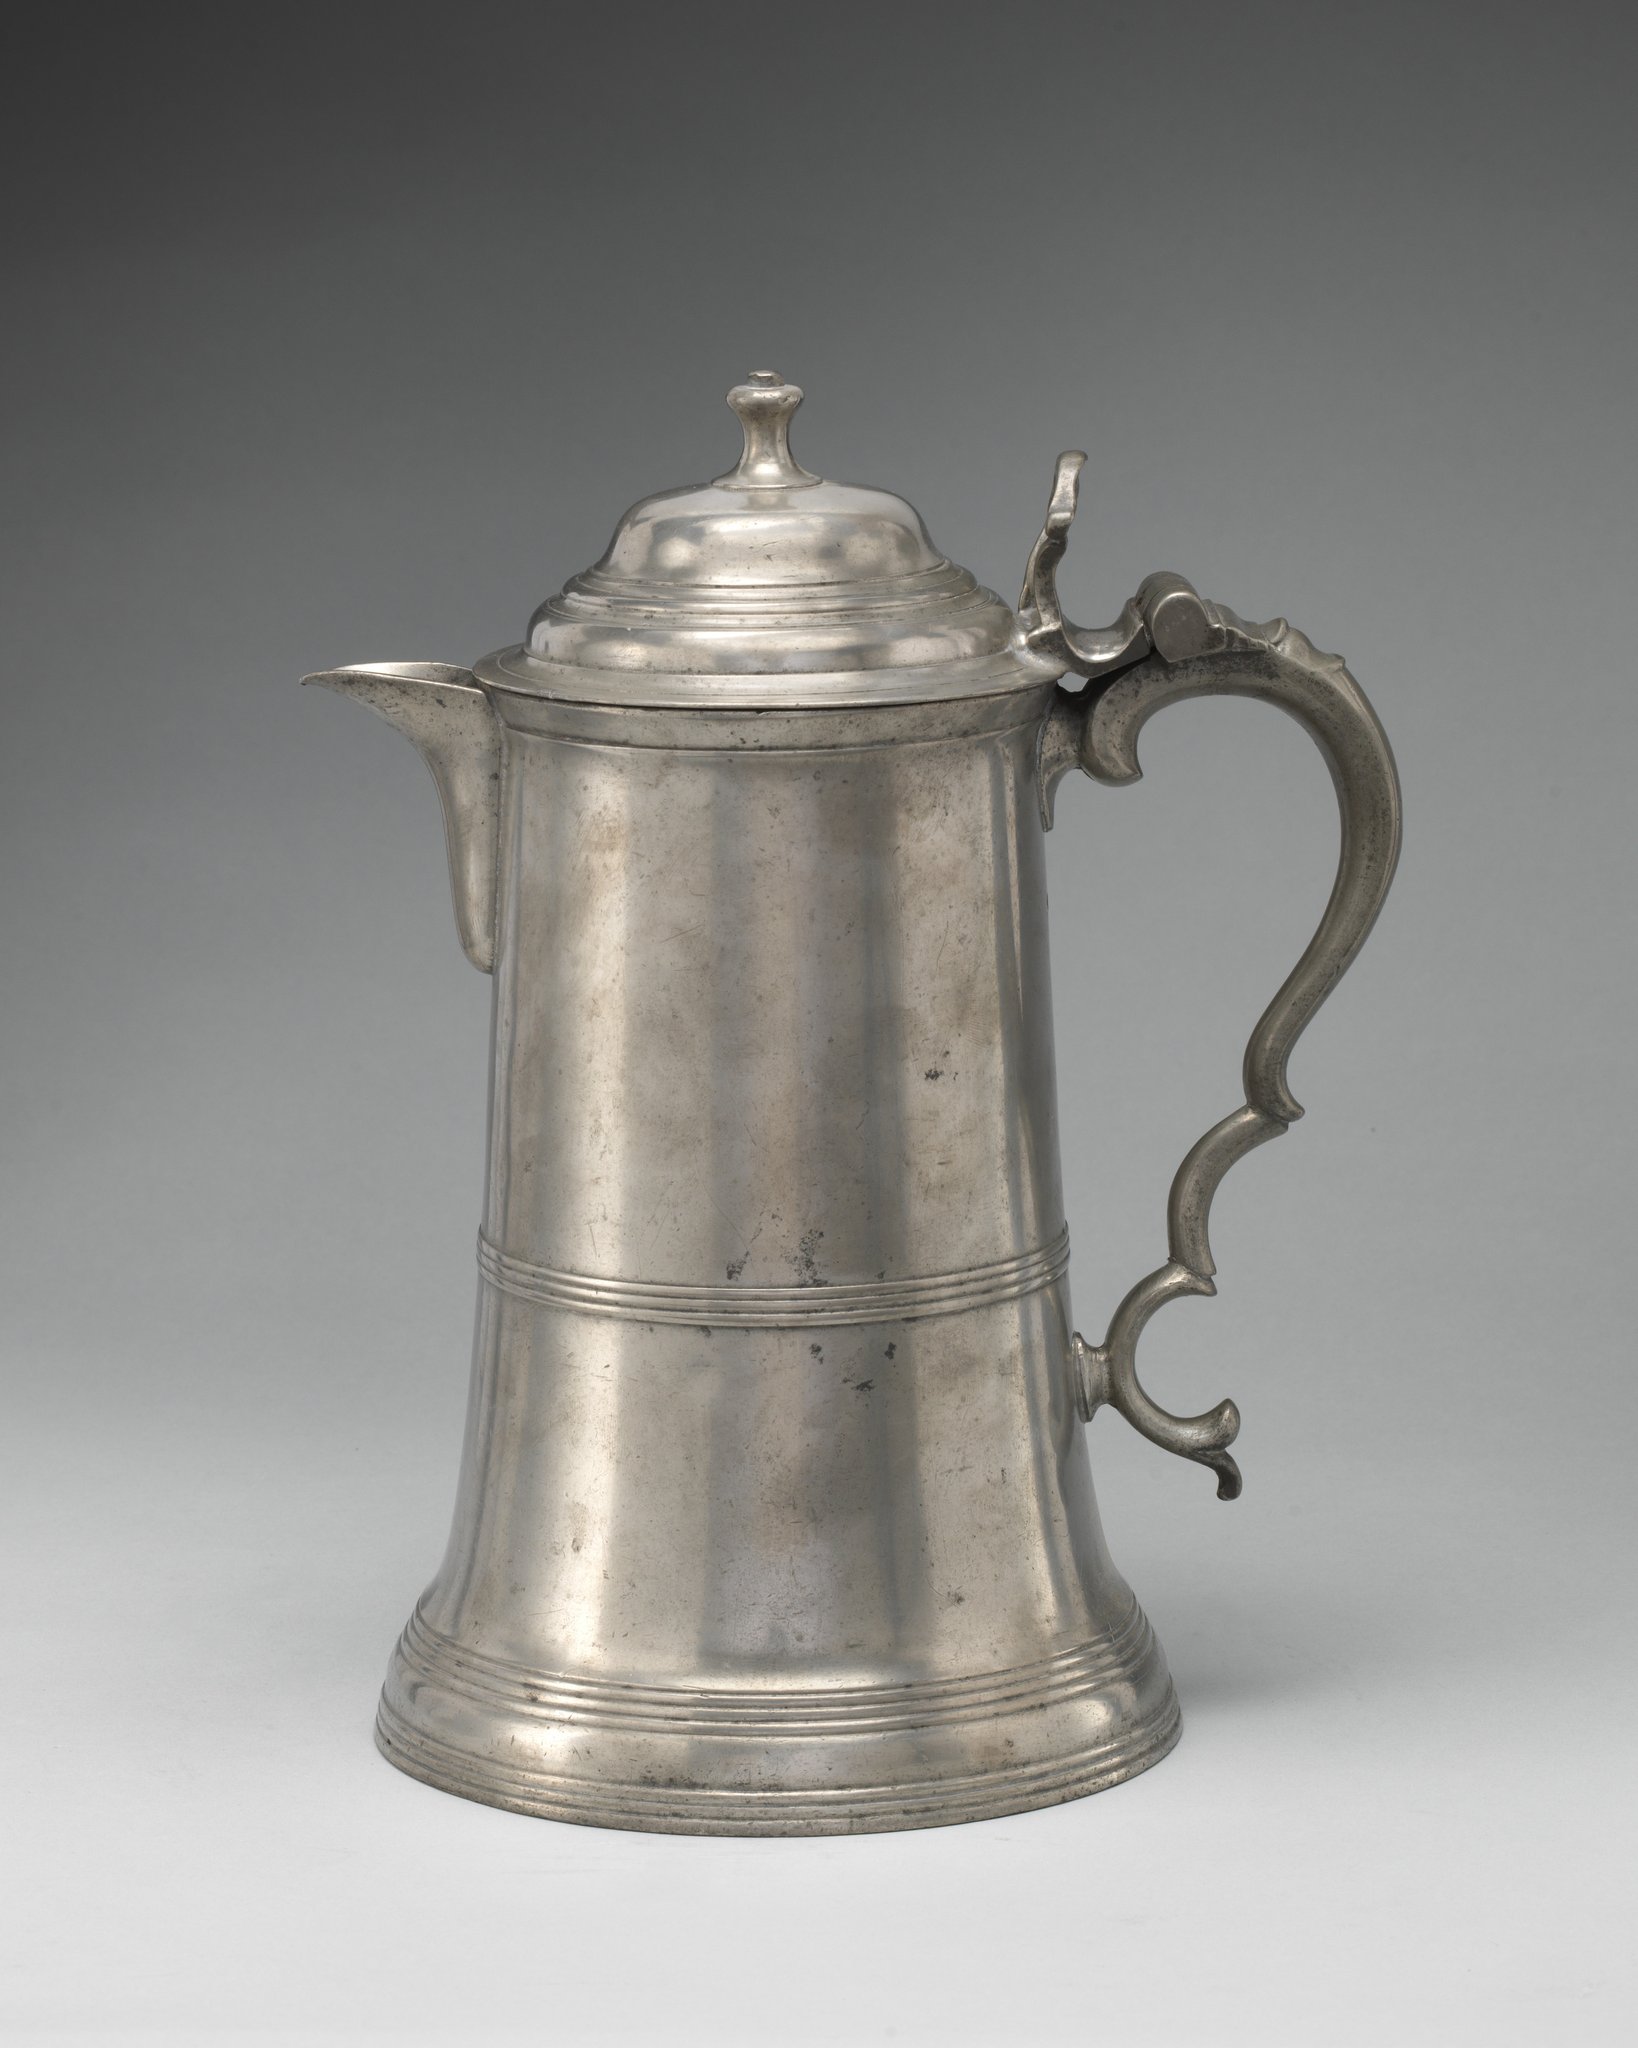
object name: flagon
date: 1701-1800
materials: pewter